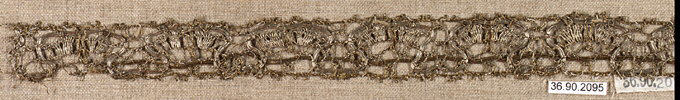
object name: piece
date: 1801-1900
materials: metal thread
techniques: lace